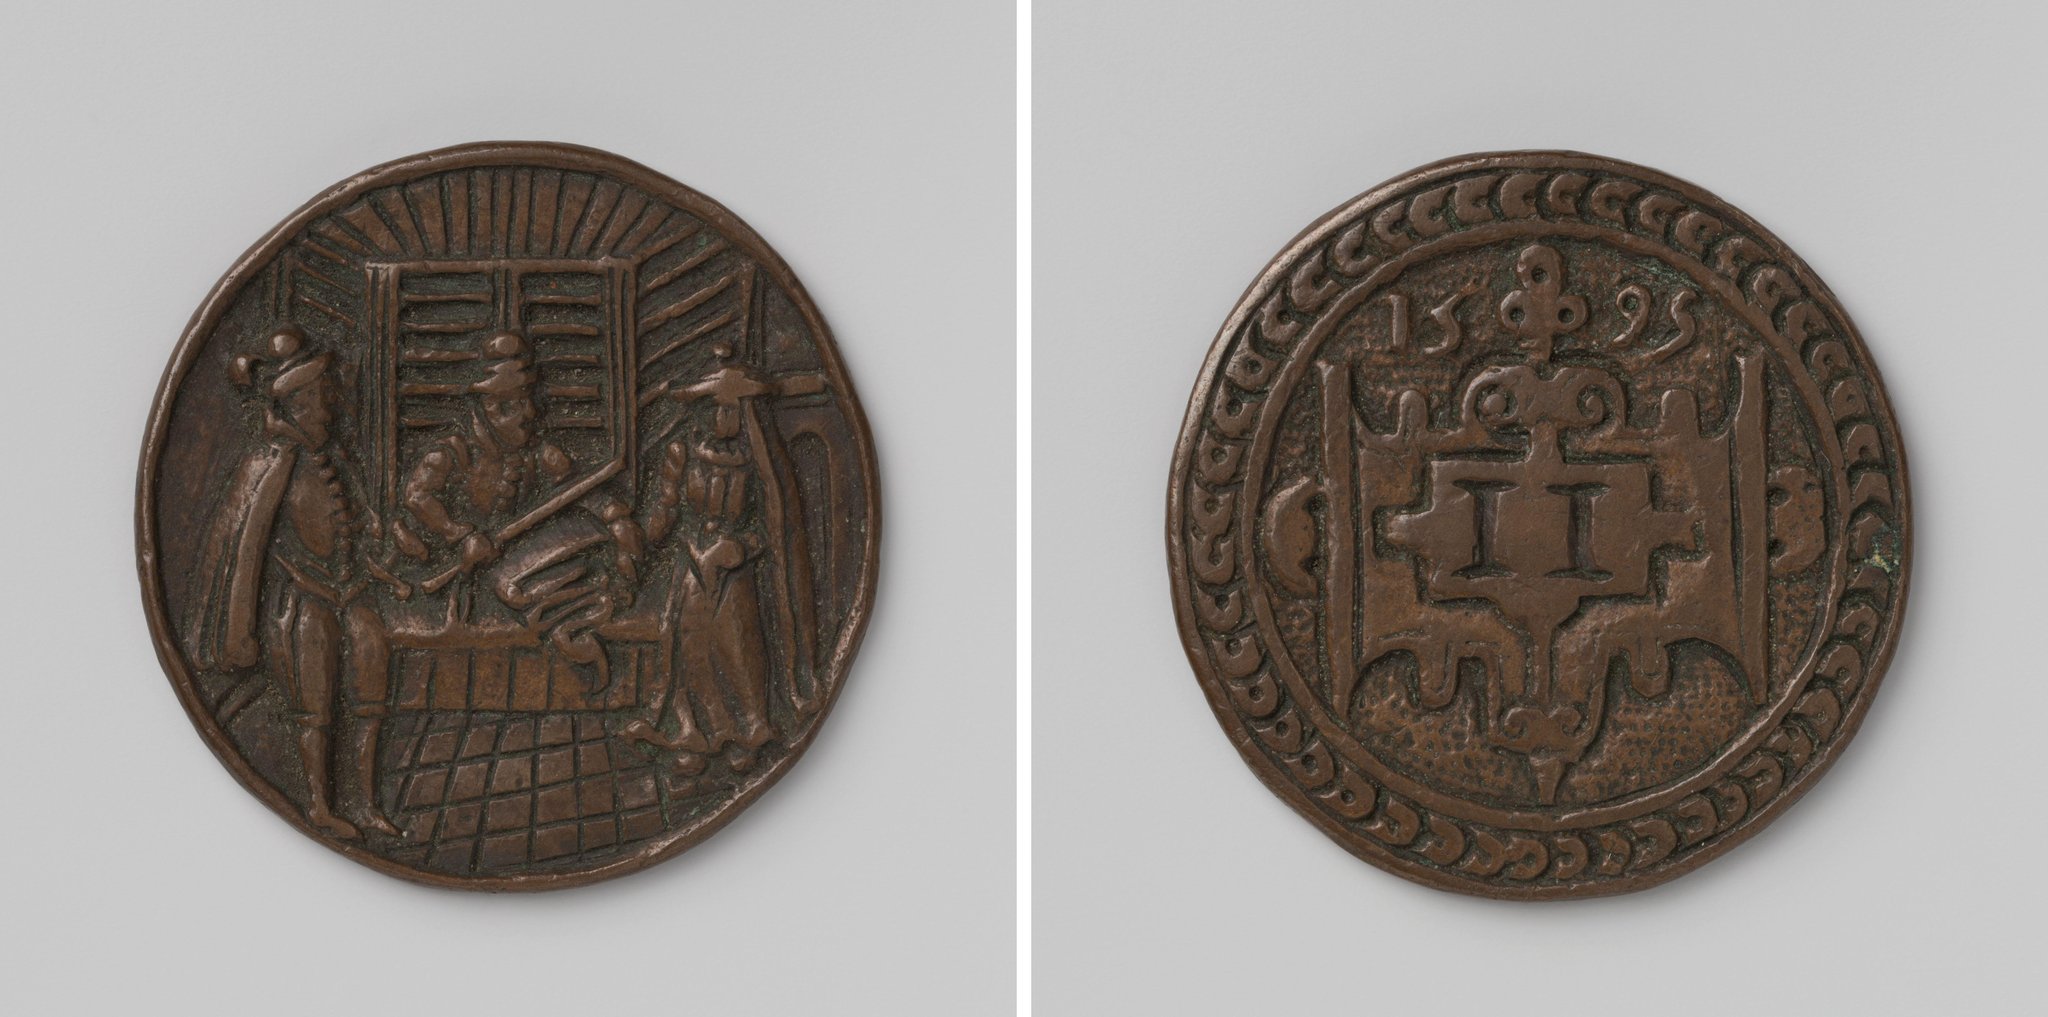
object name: medal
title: Wollenlakenkopers- en -snijdersgilde van Middelburg, gildepenning met no. 11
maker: francois baillet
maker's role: medailleur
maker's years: 1595-1603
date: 1595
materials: copper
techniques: casting, engraving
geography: middelburg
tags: middelburg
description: Koperen penning. Voorzijde: lakenkoopman, staande achter toonbank in zijn winkel meet met een el stof; links en rechts: man en vrouw. Keerzijde: cijfer 11 in versierd compartiment onder jaartal binnen rand van sikkels